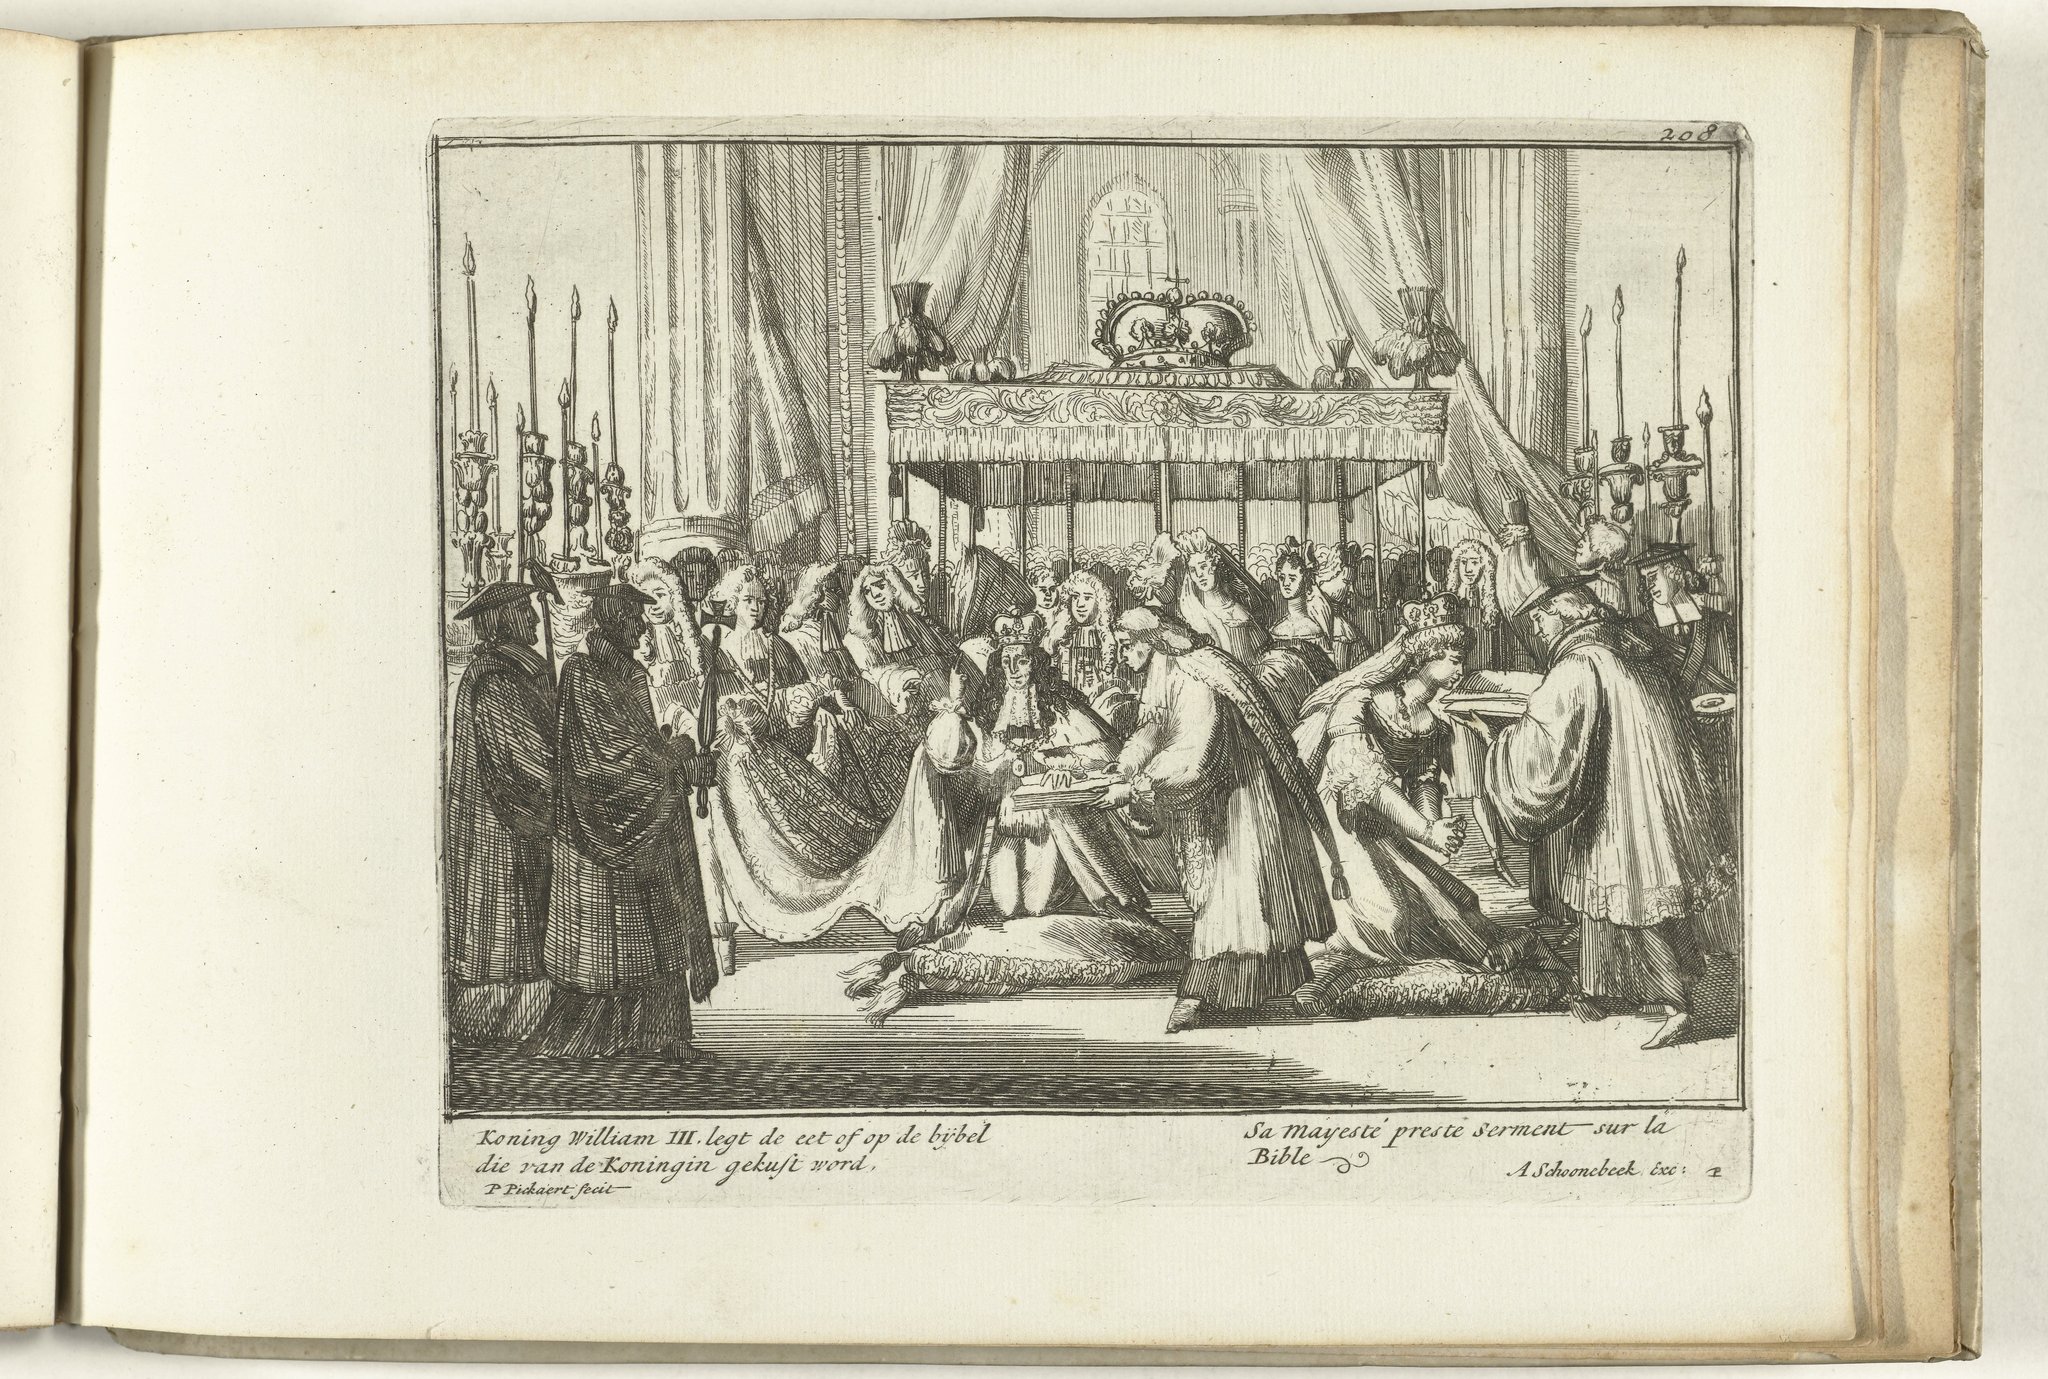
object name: print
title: Willem III legt tijdens de kroning de eed af, 1689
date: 1689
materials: paper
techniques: etching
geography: amsterdam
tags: william iii (prince of orange and king of england, scotland, and ireland), london, maria ii stuart (koningin van engeland, schotland en ierland), new ruler taking the oath, coronation of a ruler, westminster abbey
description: Tijdens de kroningsceremonie legt Willem III de eed af op de bijbel, Maria kust de bijbel, 21 april 1689. Genummerd rechtsboven: 208. Plaat P in de serie 'Engelants schouwtoneel' over de Glorious Revolution 1688-1689 (tweede deel). Met onderschriften in het Nederlands en Frans.